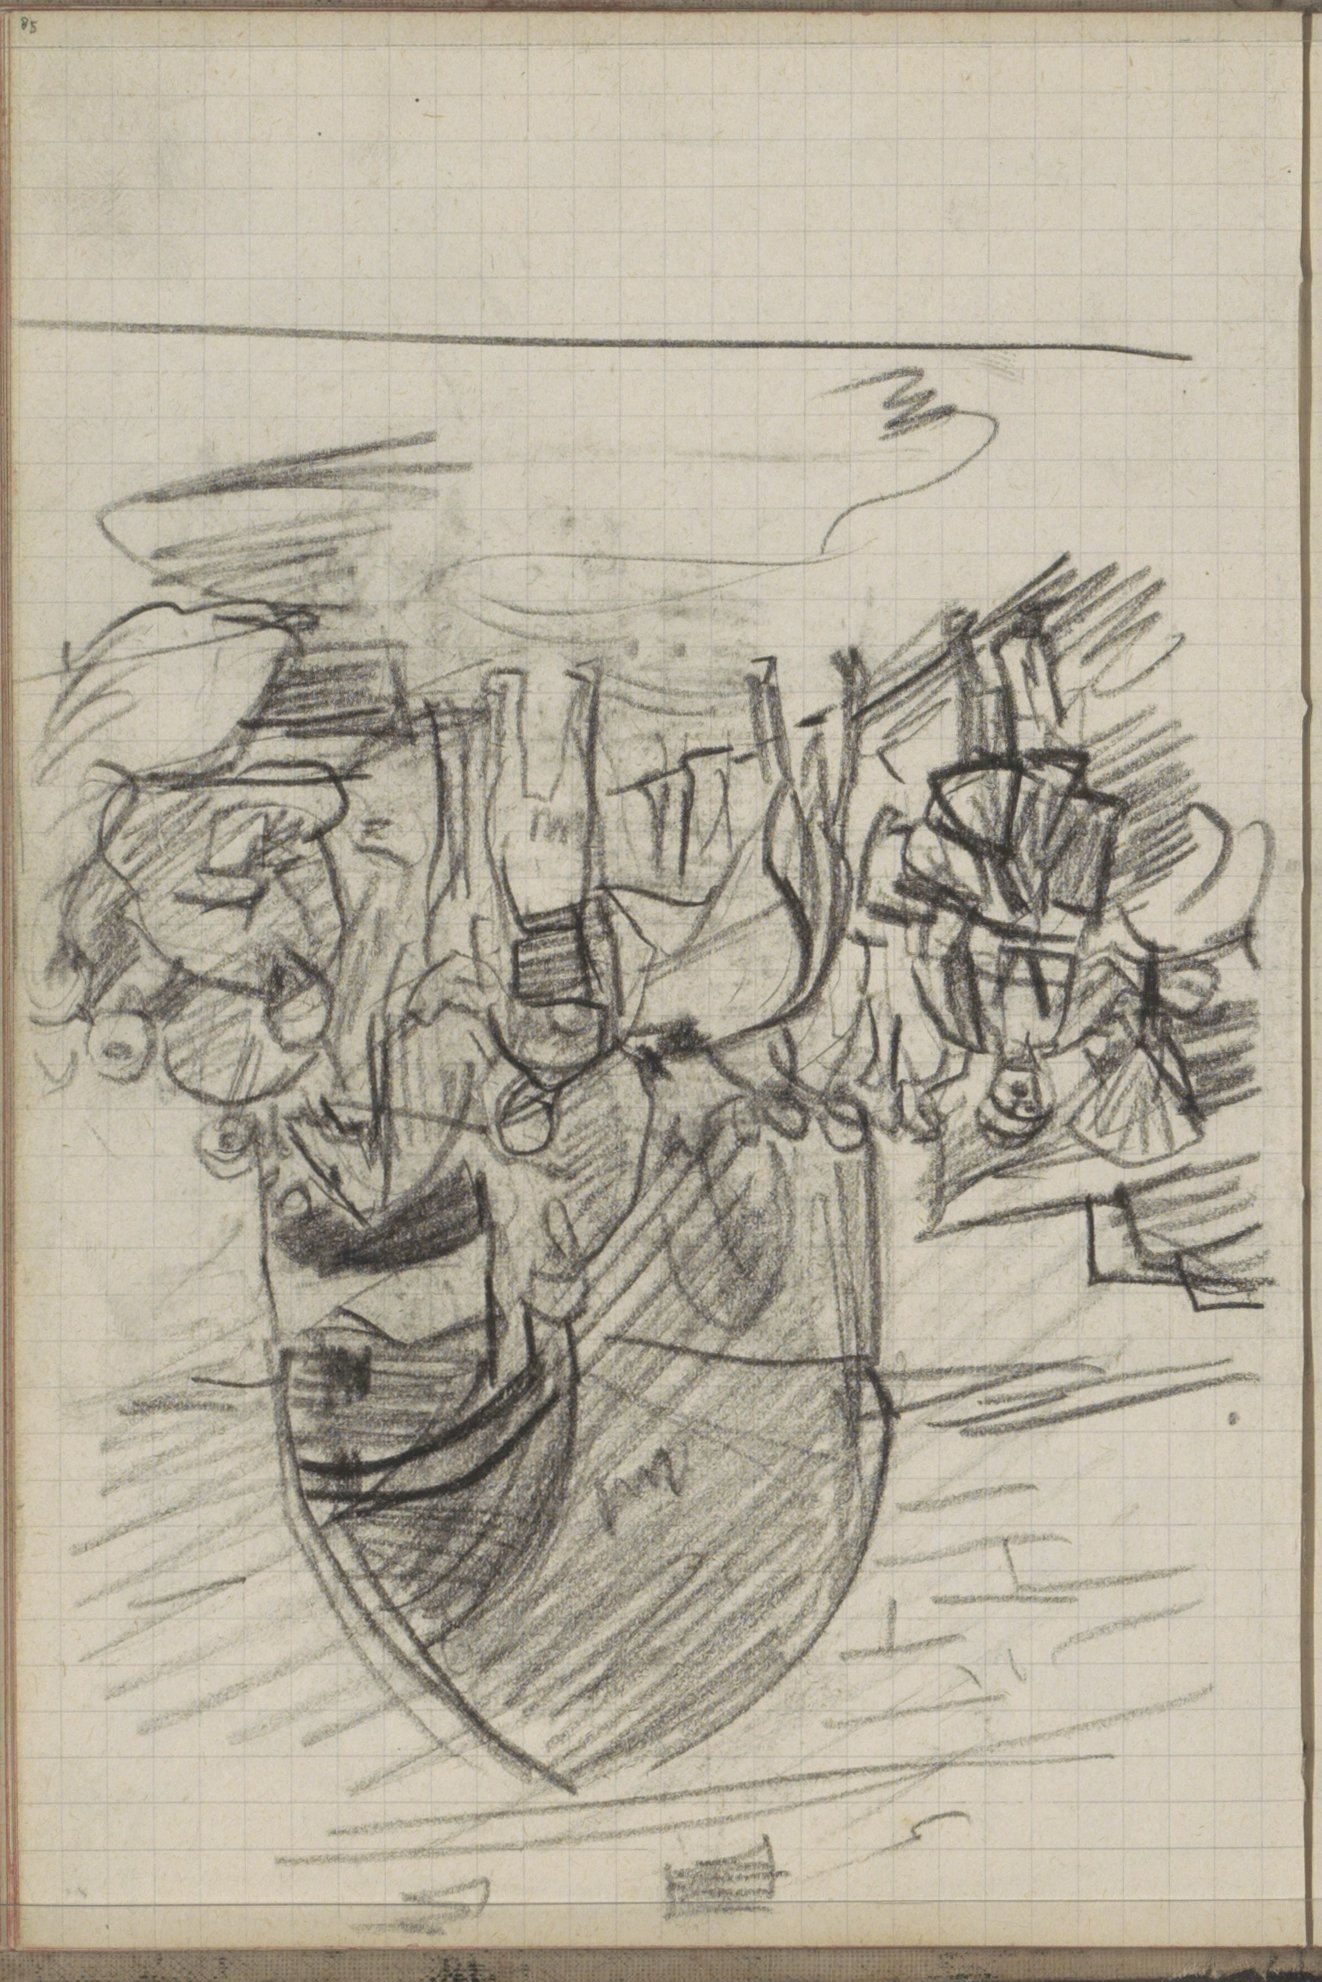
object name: sketchbook leaf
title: Figuren voor een portaal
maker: marius bauer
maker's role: draughtsman, print maker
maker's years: 1867-1932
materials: chalk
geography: istanbul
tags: riding a horse, ass, or mule; rider, horseman, asiatic races and peoples, street (+ city(-scape) with figures, staffage)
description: Waaronder lopende en zittende figuren en een figuur op een paard. Pagina 85 uit een schetsboek met 54 bladen.